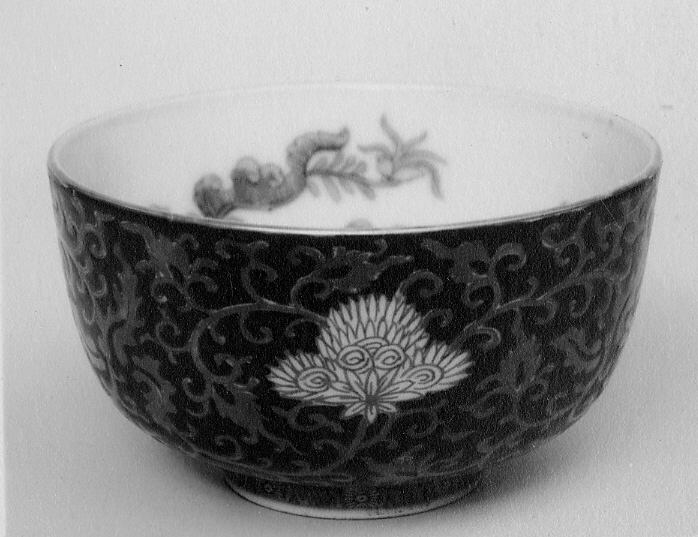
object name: cup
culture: japanese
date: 1800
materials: enamel, porcelain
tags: flowers,leaves